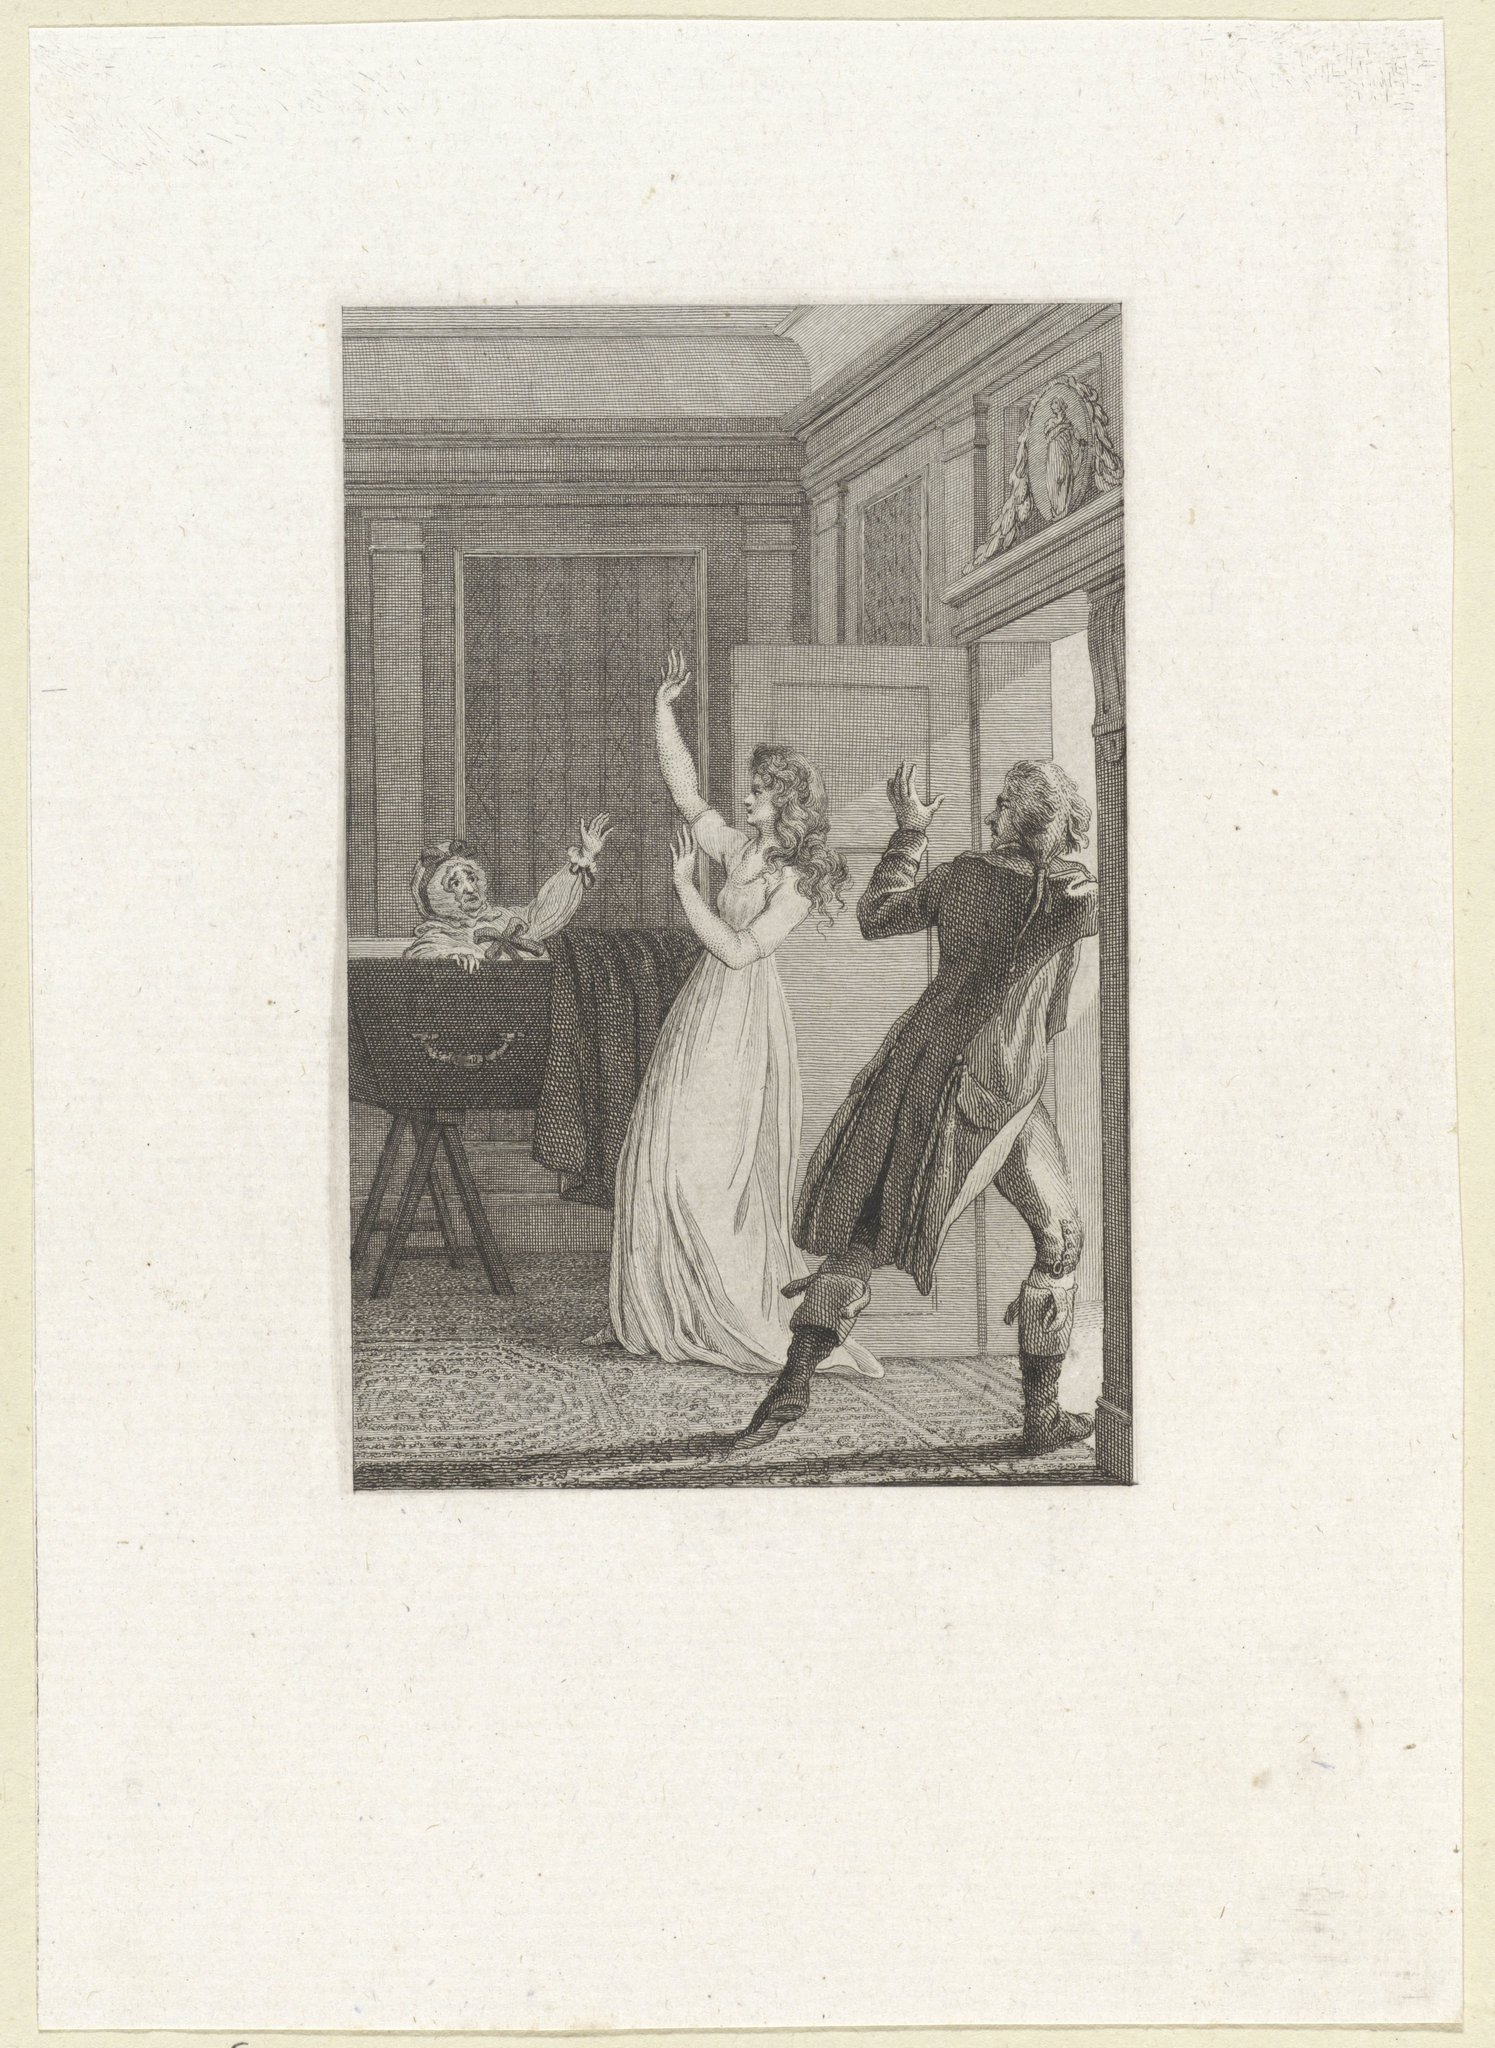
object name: print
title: Dood gewaande baby laat een vrouw en een man schrikken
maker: reinier vinkeles (i)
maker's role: draughtsman, print maker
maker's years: 1741-1816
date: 1798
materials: paper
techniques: engraving, etching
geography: amsterdam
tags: apparent death, infant, baby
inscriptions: collector's mark: Lugt 240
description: Proefdruk van een prent die mogelijk ook gebruikt is als illustratie in: De teleurgestelde verleider, of De schĳndoode. Amsterdam: erven van Pieter Meĳer en Gerrit Warnars, 1798.